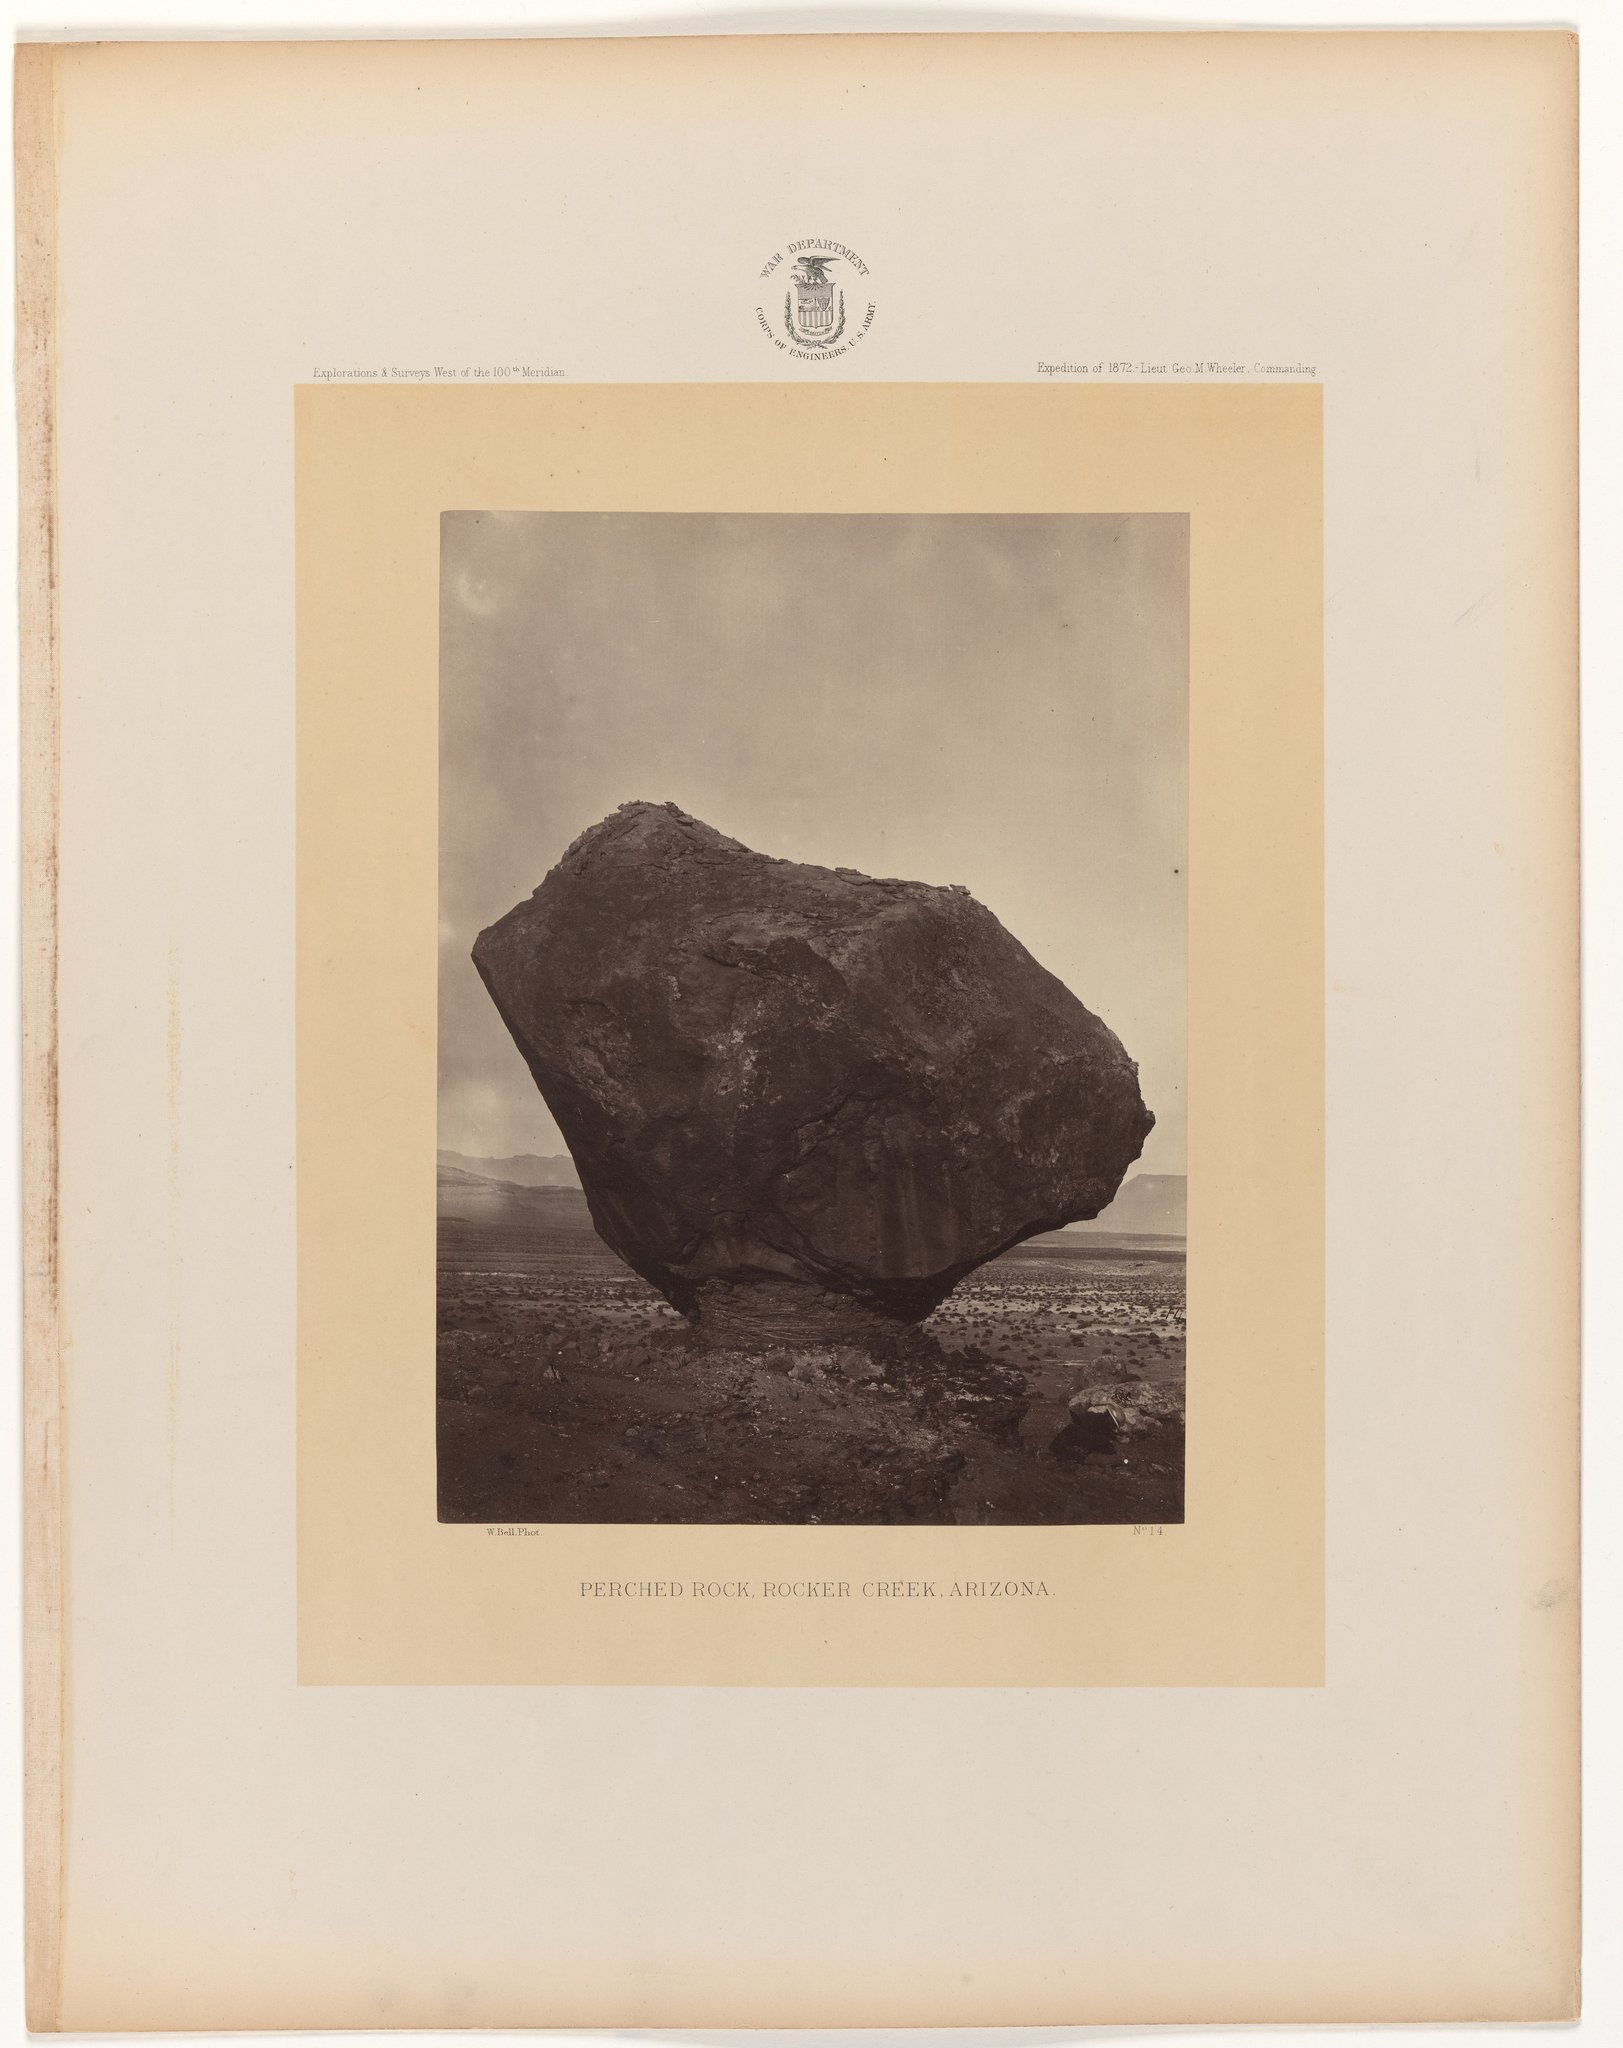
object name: photograph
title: Perched Rock, Rocker Creek, Arizona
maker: william h. bell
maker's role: artist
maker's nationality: american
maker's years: 1830-1910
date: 1872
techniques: albumen silver print, glass negative